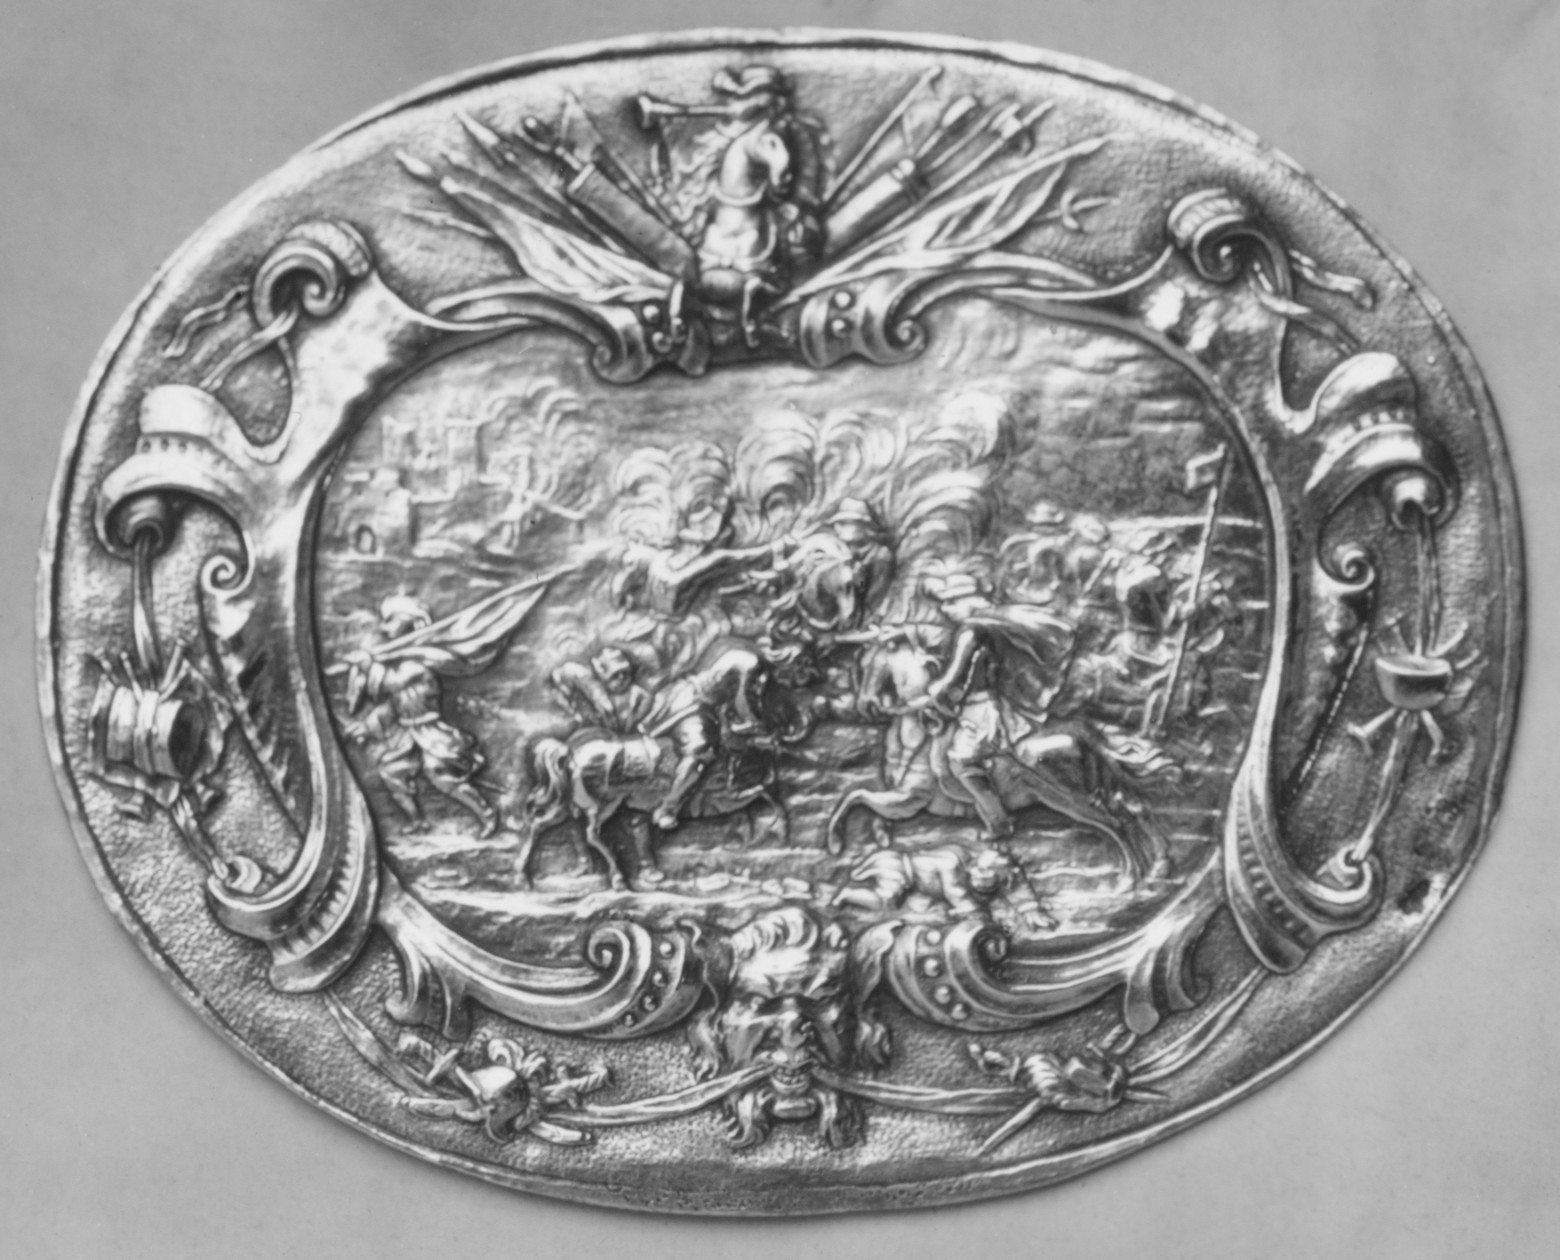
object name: plaque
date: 1801-1900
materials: silver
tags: battles,horses